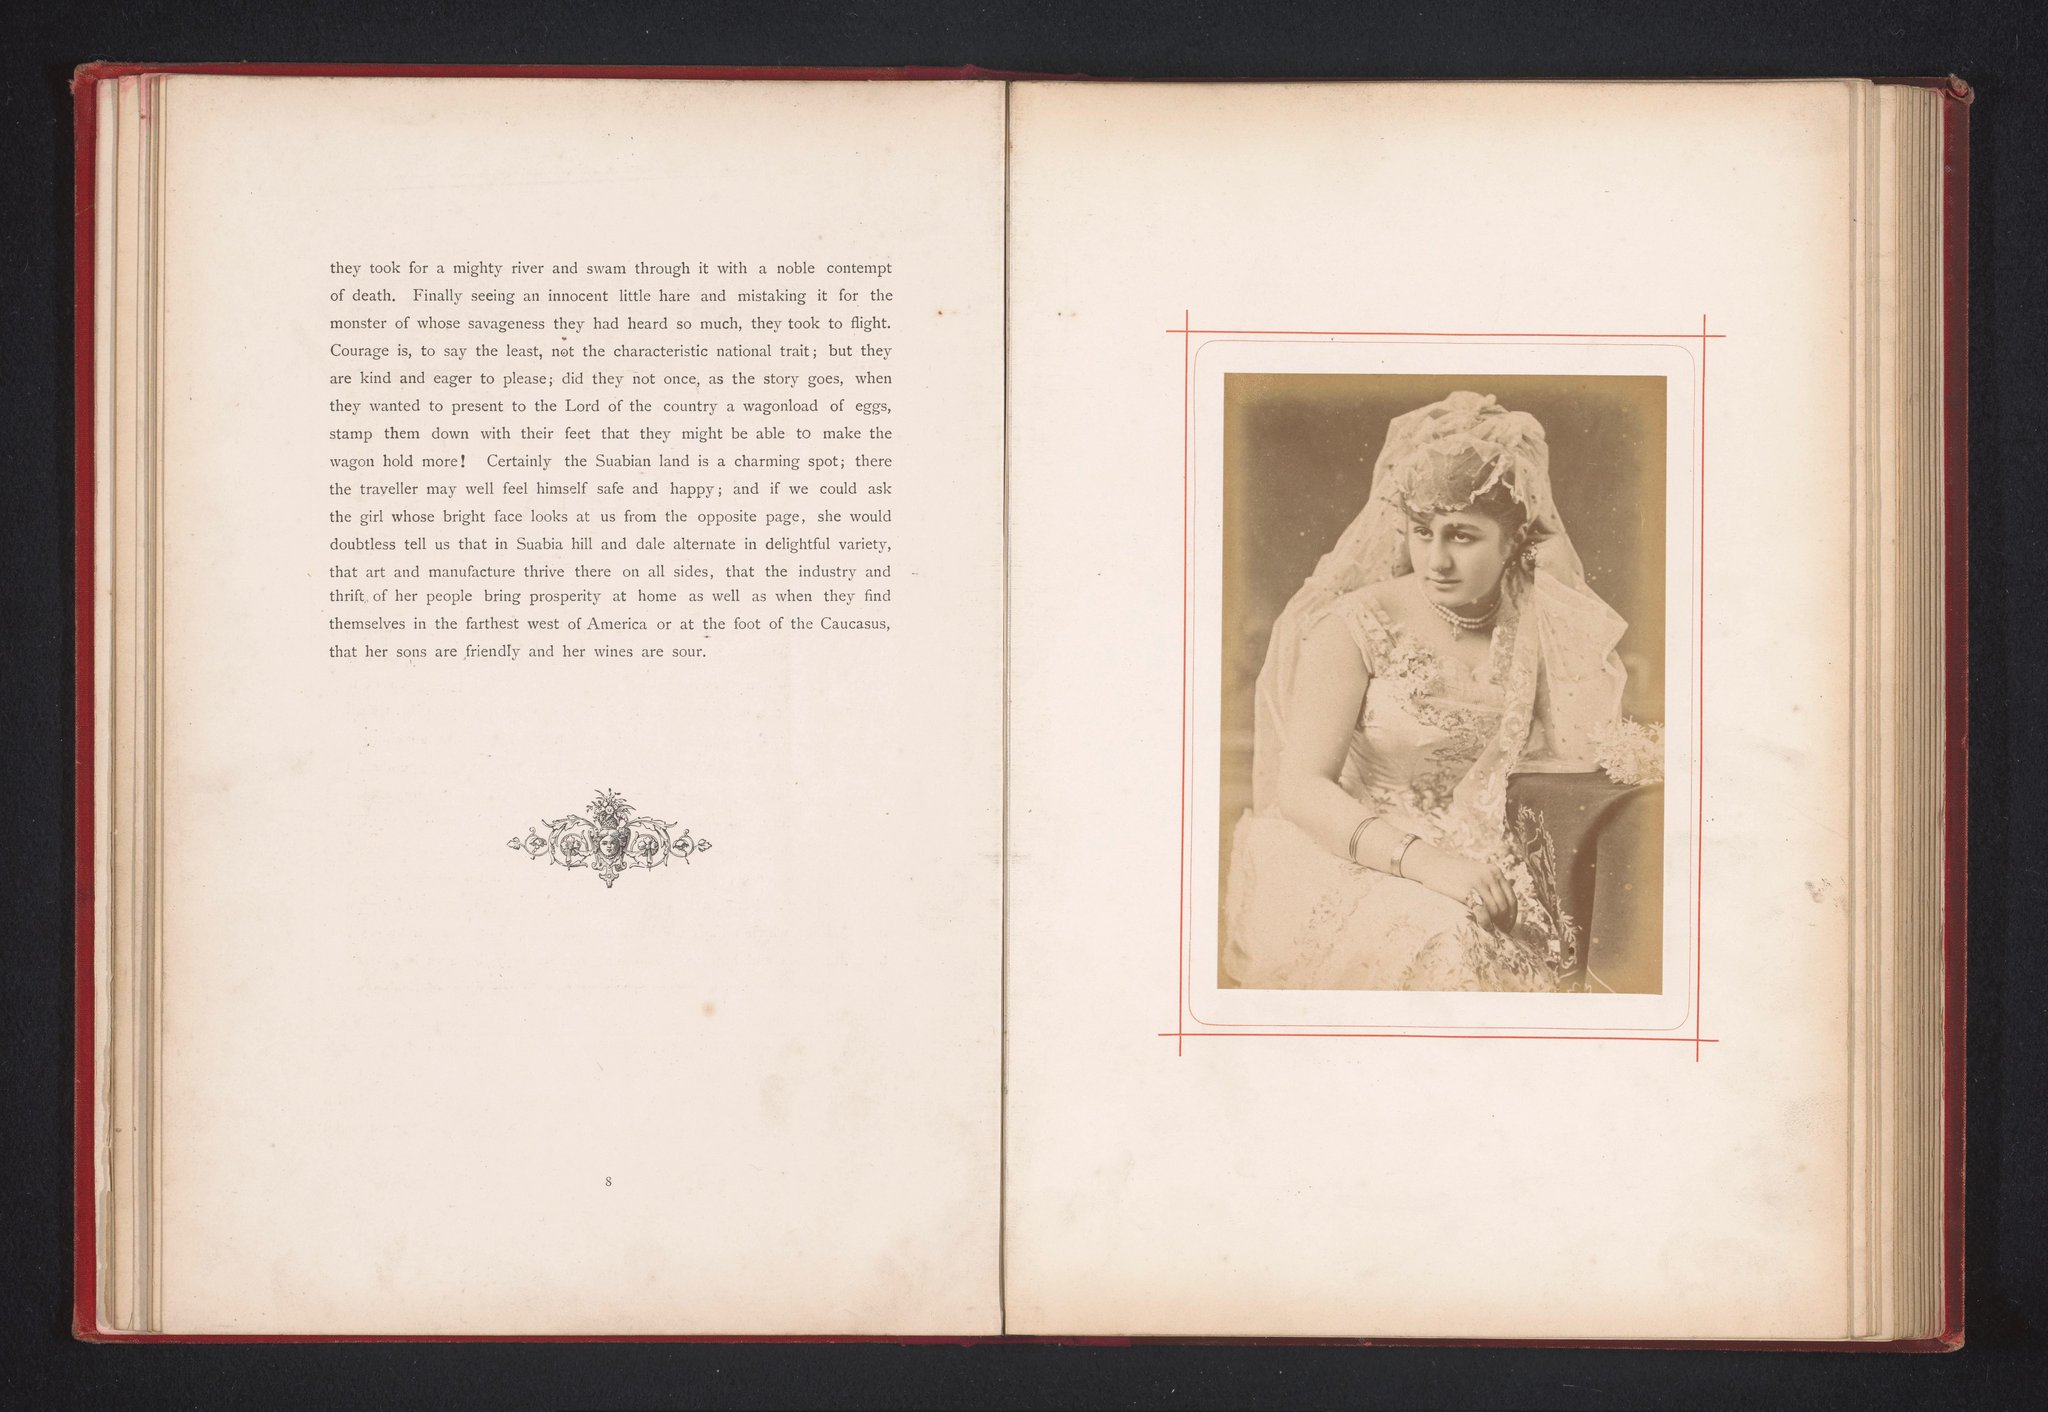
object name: photograph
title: Portret van een onbekende vrouw in klederdracht uit Oostenrijk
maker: Anonymous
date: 1876-1886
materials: photographic support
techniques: albumen print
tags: folk costume, regional costume, anonymous historical person portrayed - bb - woman